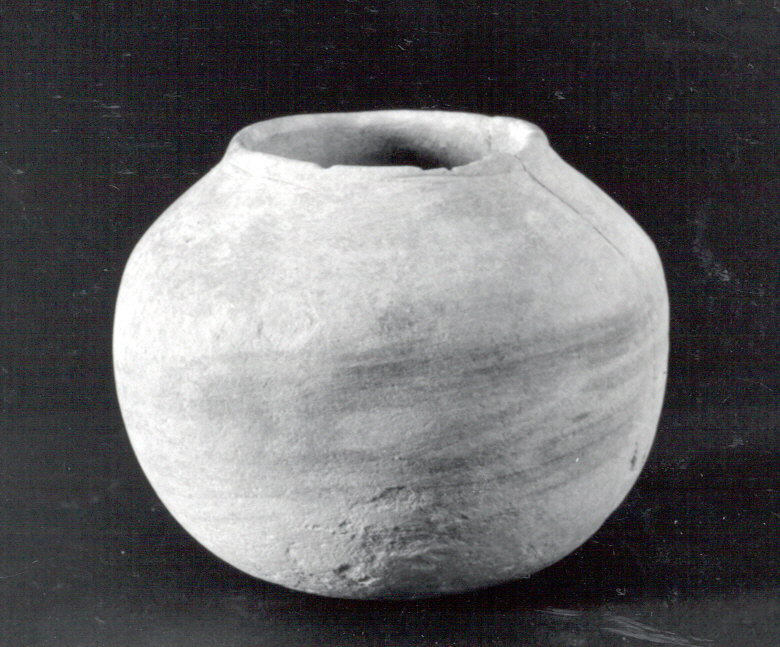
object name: jar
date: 7000-5001 BCE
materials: limestone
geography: syria